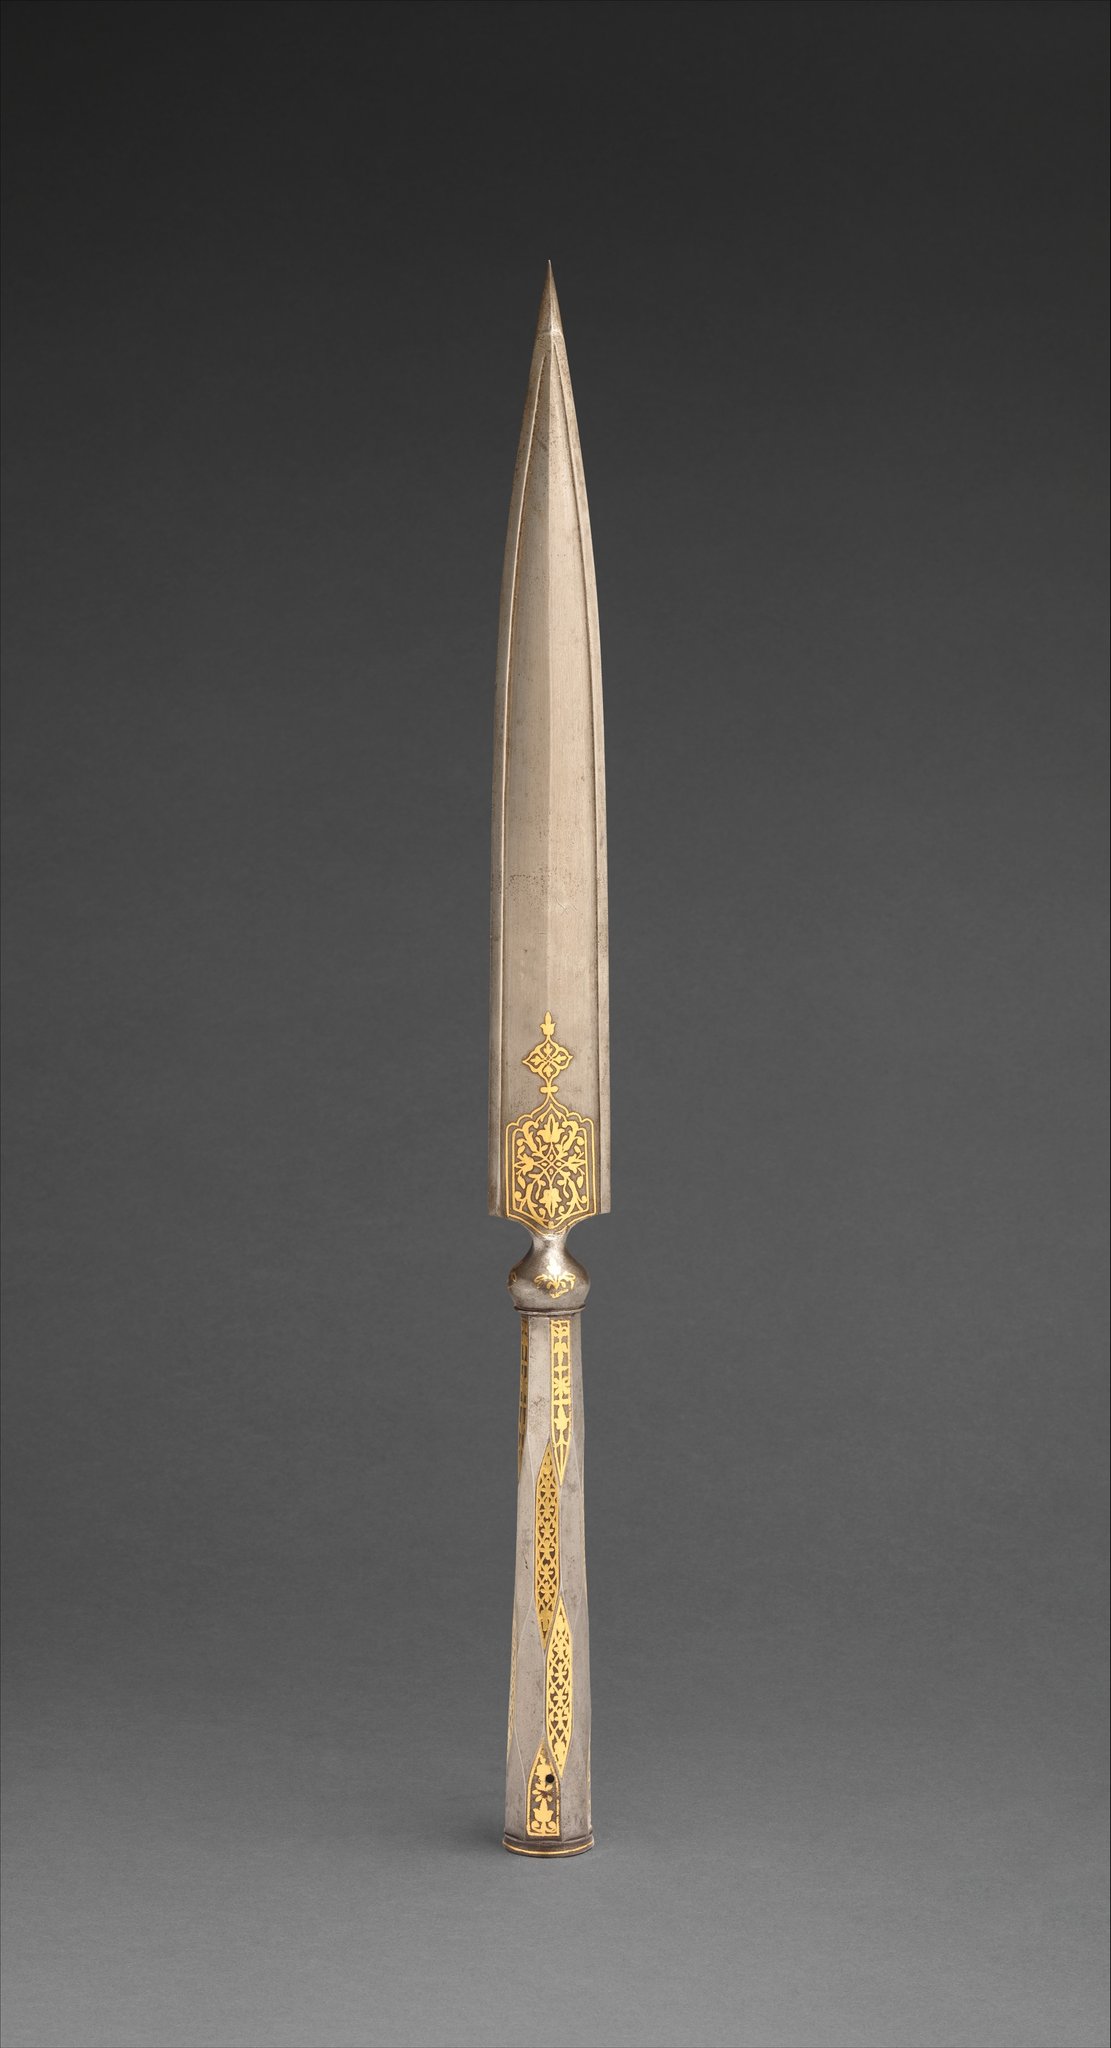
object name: spear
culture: north indian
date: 1701-1800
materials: gold, steel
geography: north india